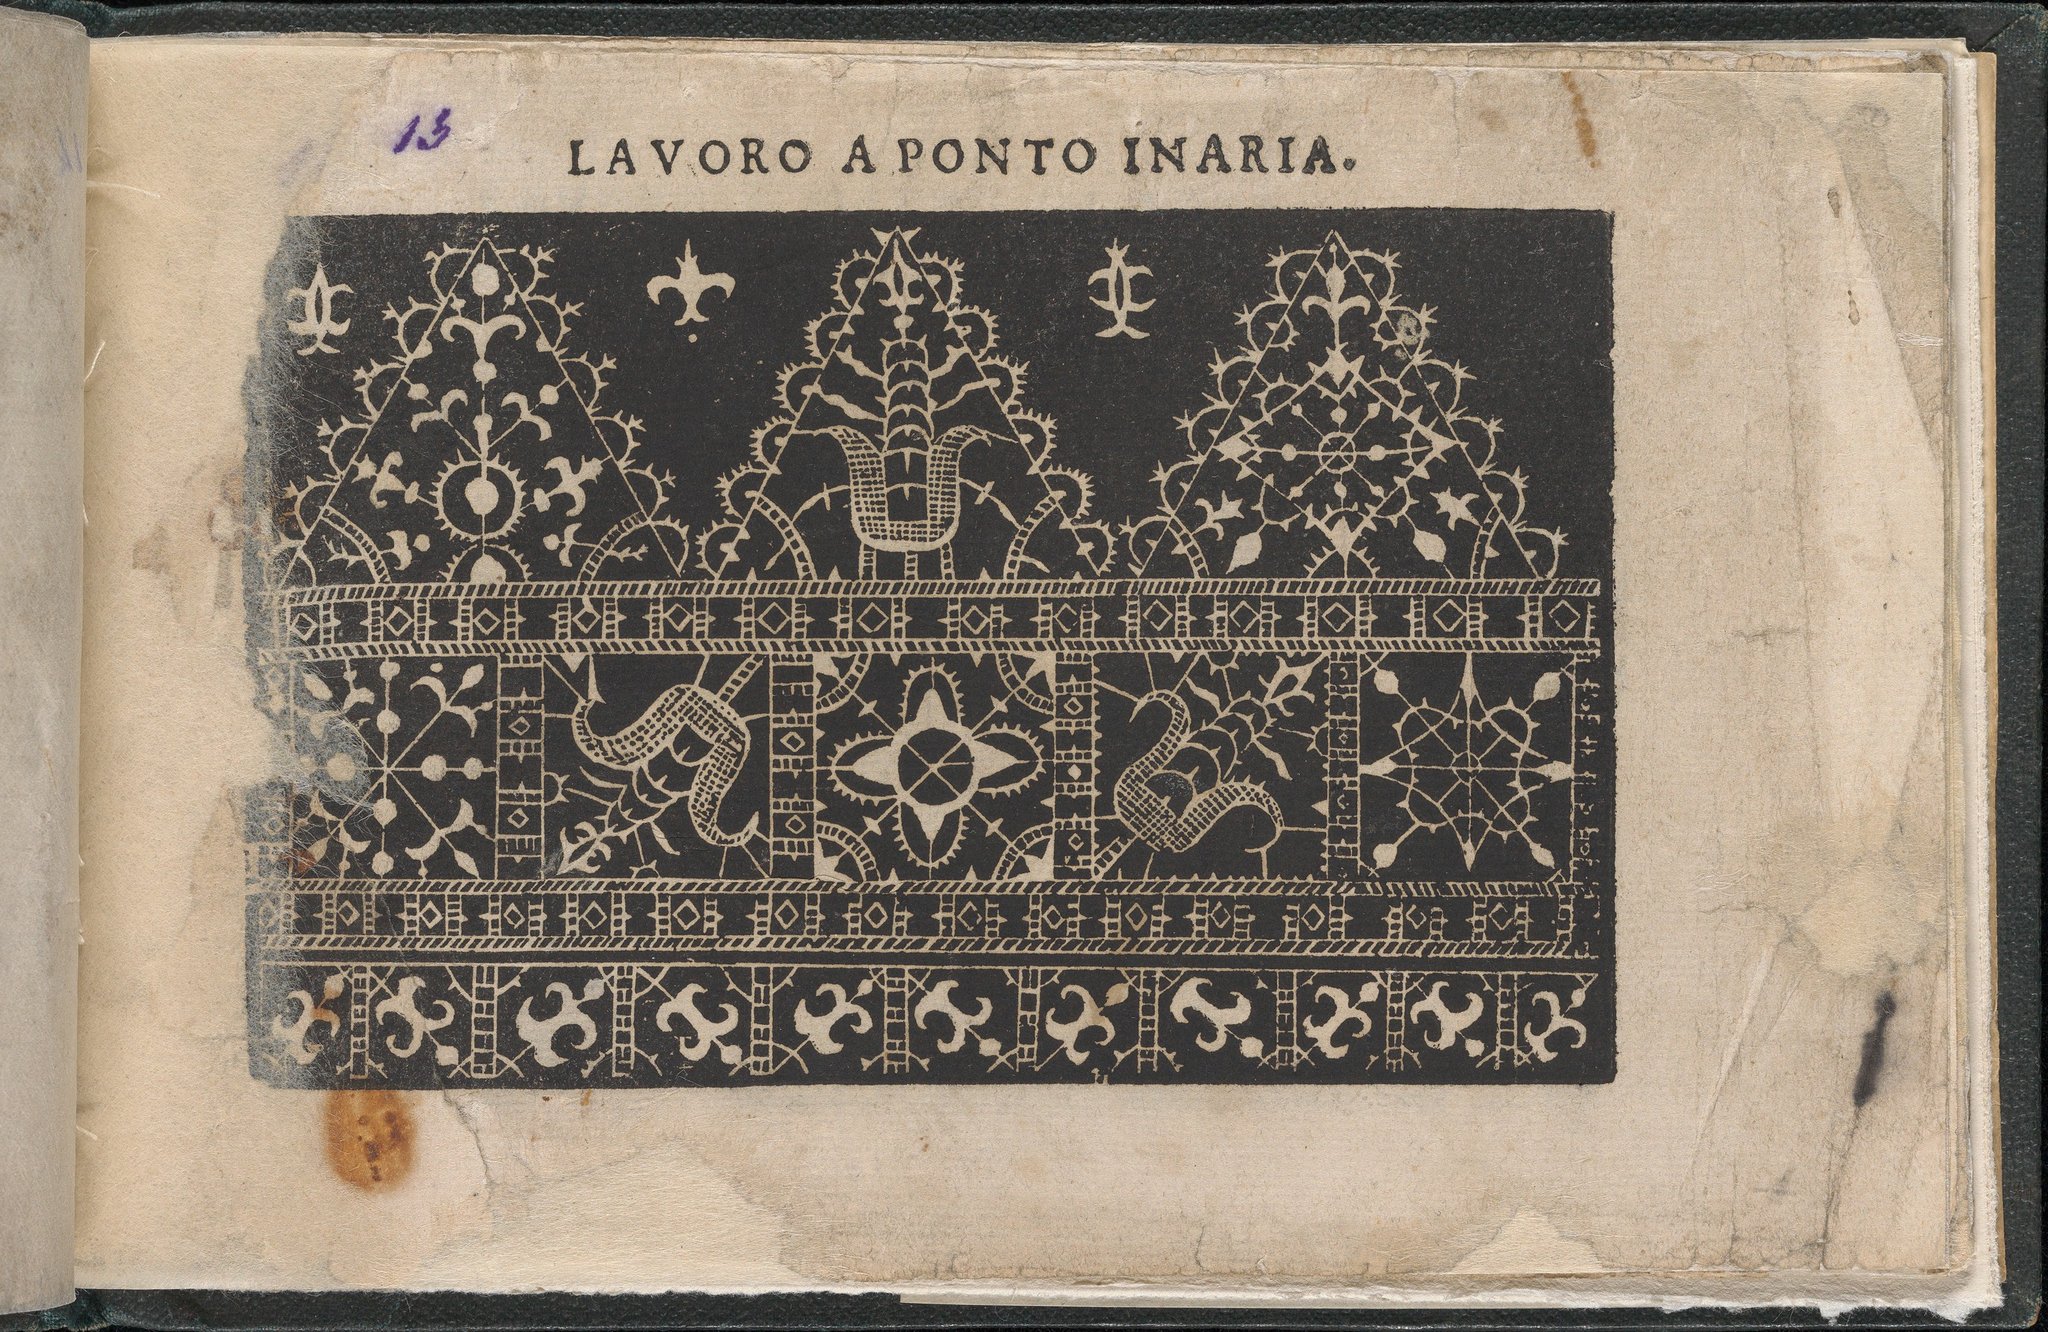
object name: book print ornament architecture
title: Gemma pretiosa della virtuose donne, page 15 (recto)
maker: isabella catanea parasole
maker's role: designer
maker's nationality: italian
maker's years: 1565-1625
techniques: woodcut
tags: ornament